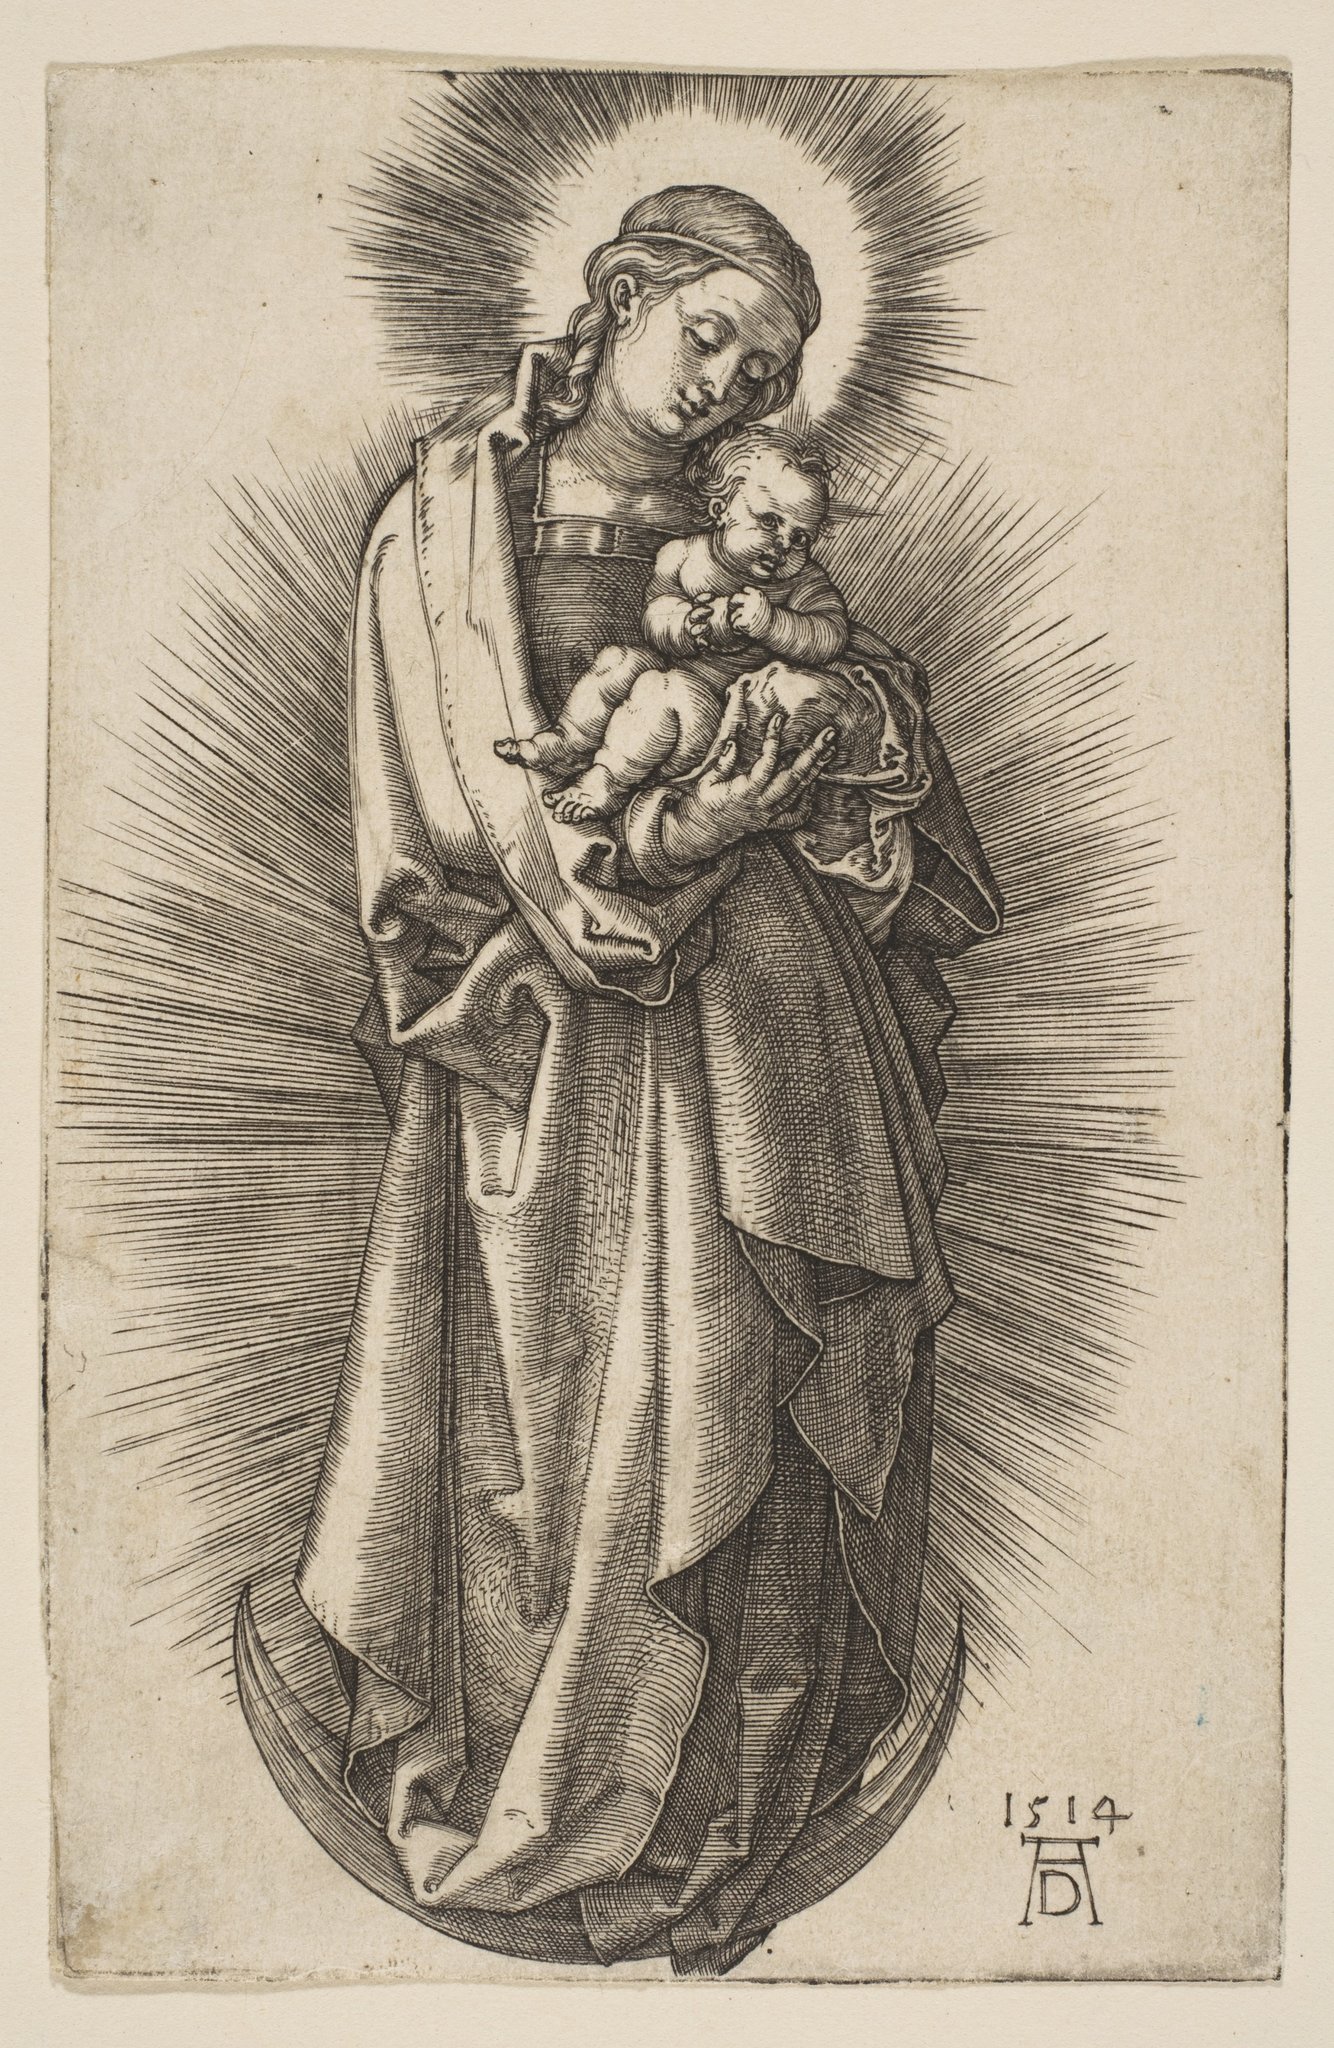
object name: print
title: Virgin and Child on the Crescent with a Diadem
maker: albrecht dürer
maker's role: artist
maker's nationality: german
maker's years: 1471-1528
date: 1514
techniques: engraving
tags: madonna and child